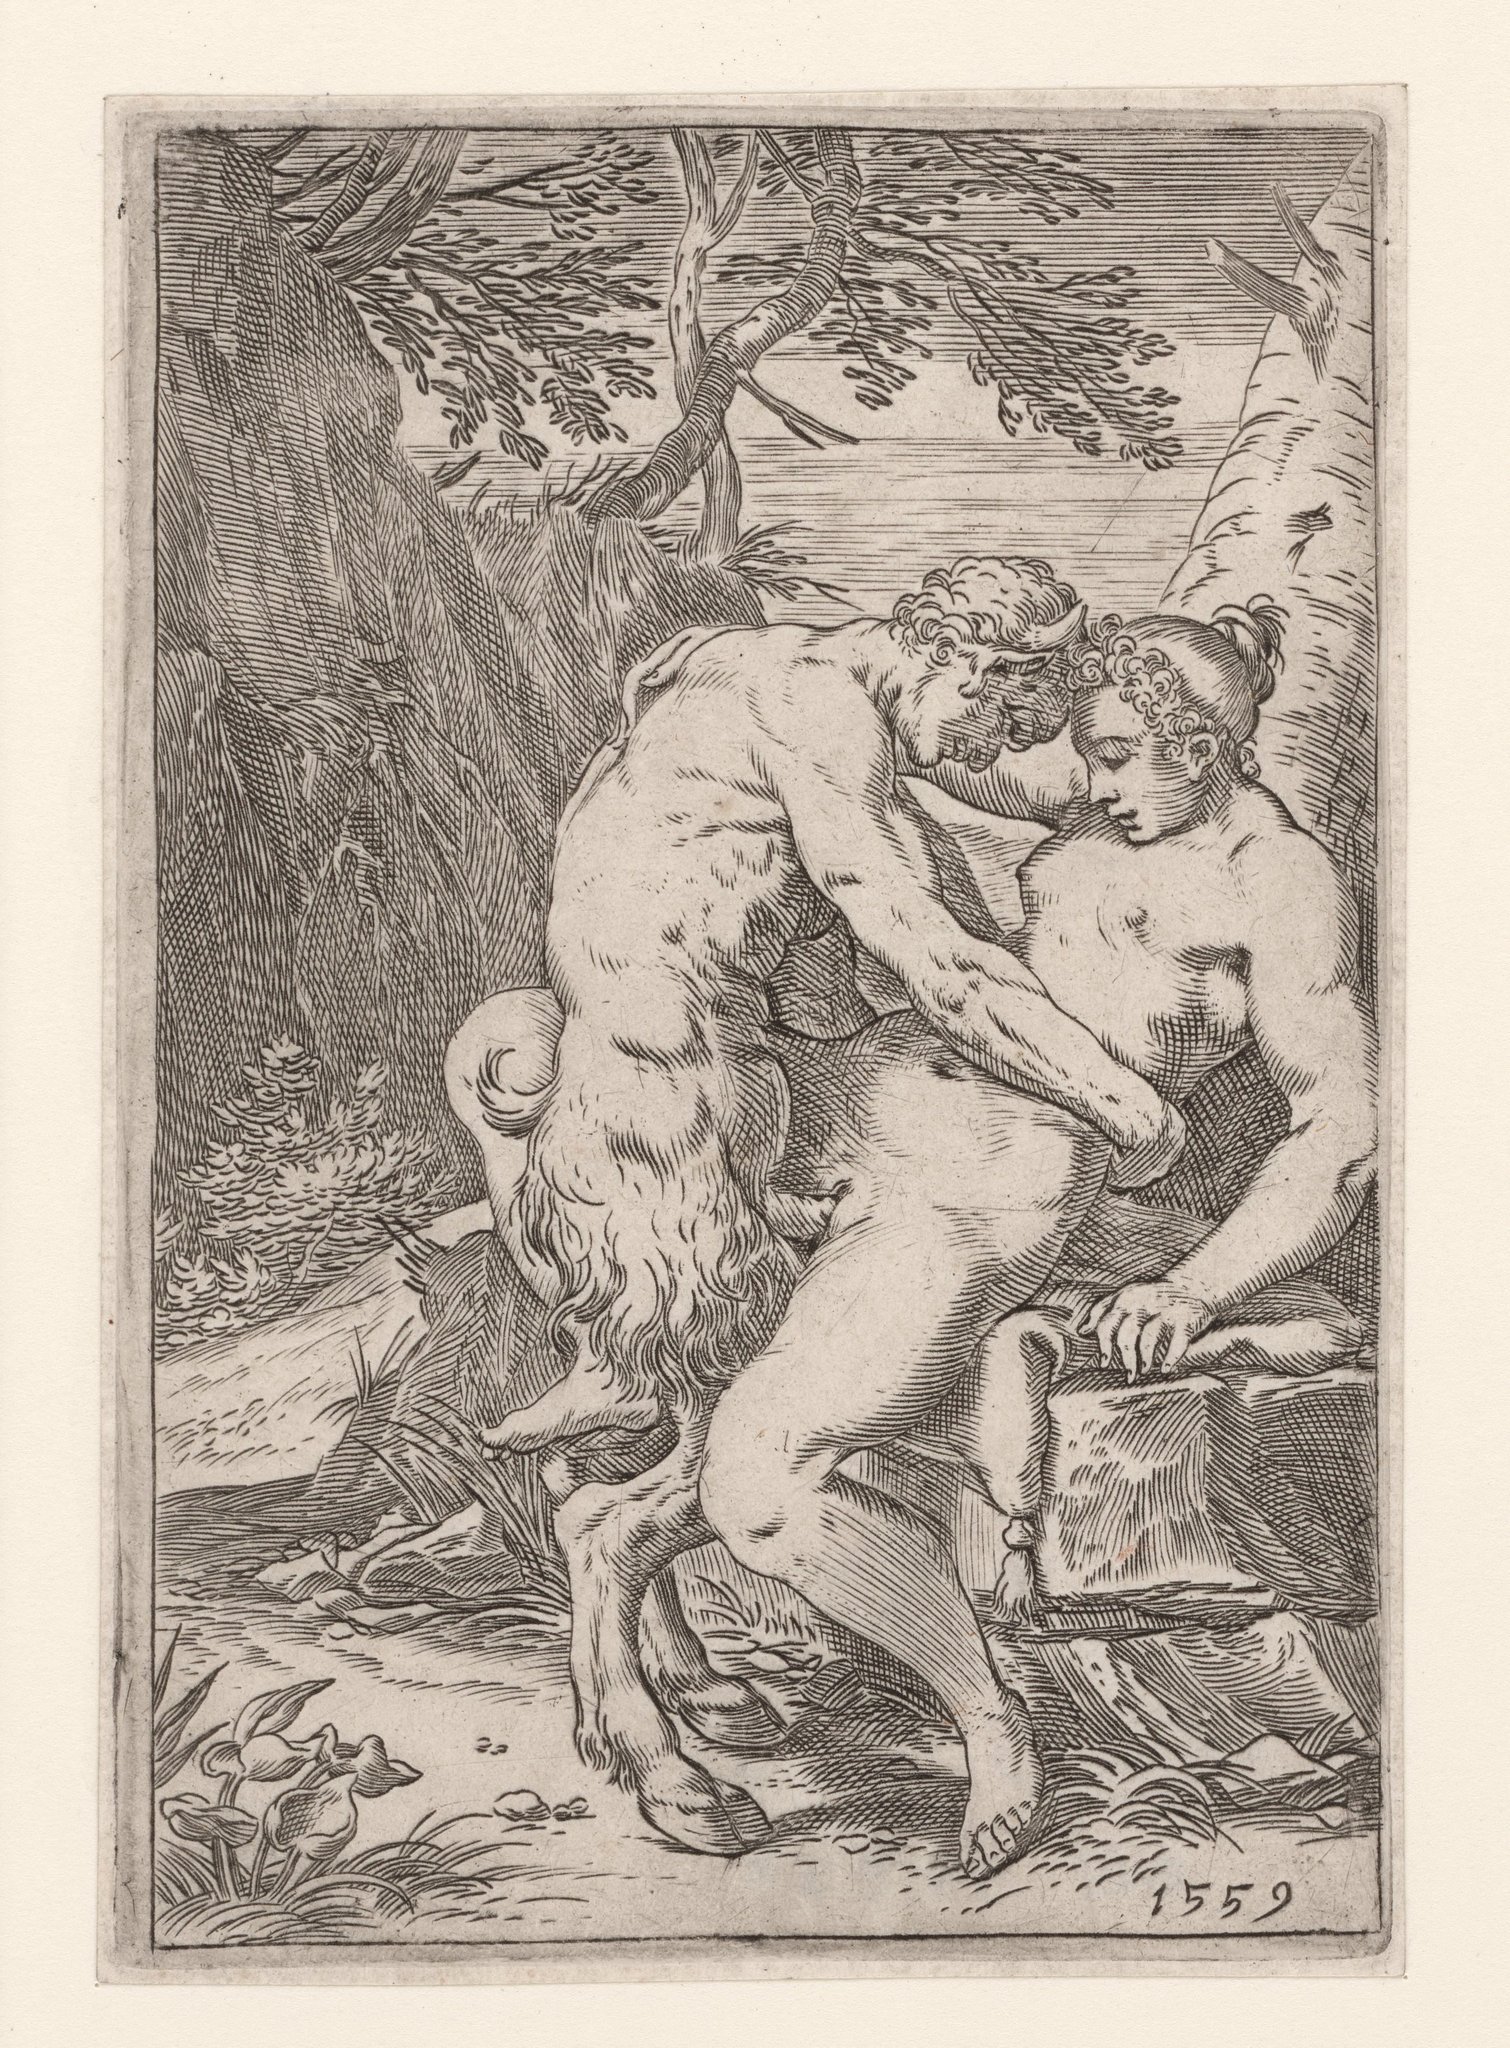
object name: print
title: Venus en Amor in een landschap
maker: agostino carracci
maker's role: draughtsman, painter, print maker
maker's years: 1557-1602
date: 1599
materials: paper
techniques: engraving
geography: italy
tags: venus and cupid (cupid not being mere attribute)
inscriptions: collector's mark: Lugt 240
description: Venus leunt tegen een boom. Amor slaapt op de voorgrond. Op de achtergrond zijn boeren aan het werk op het land.